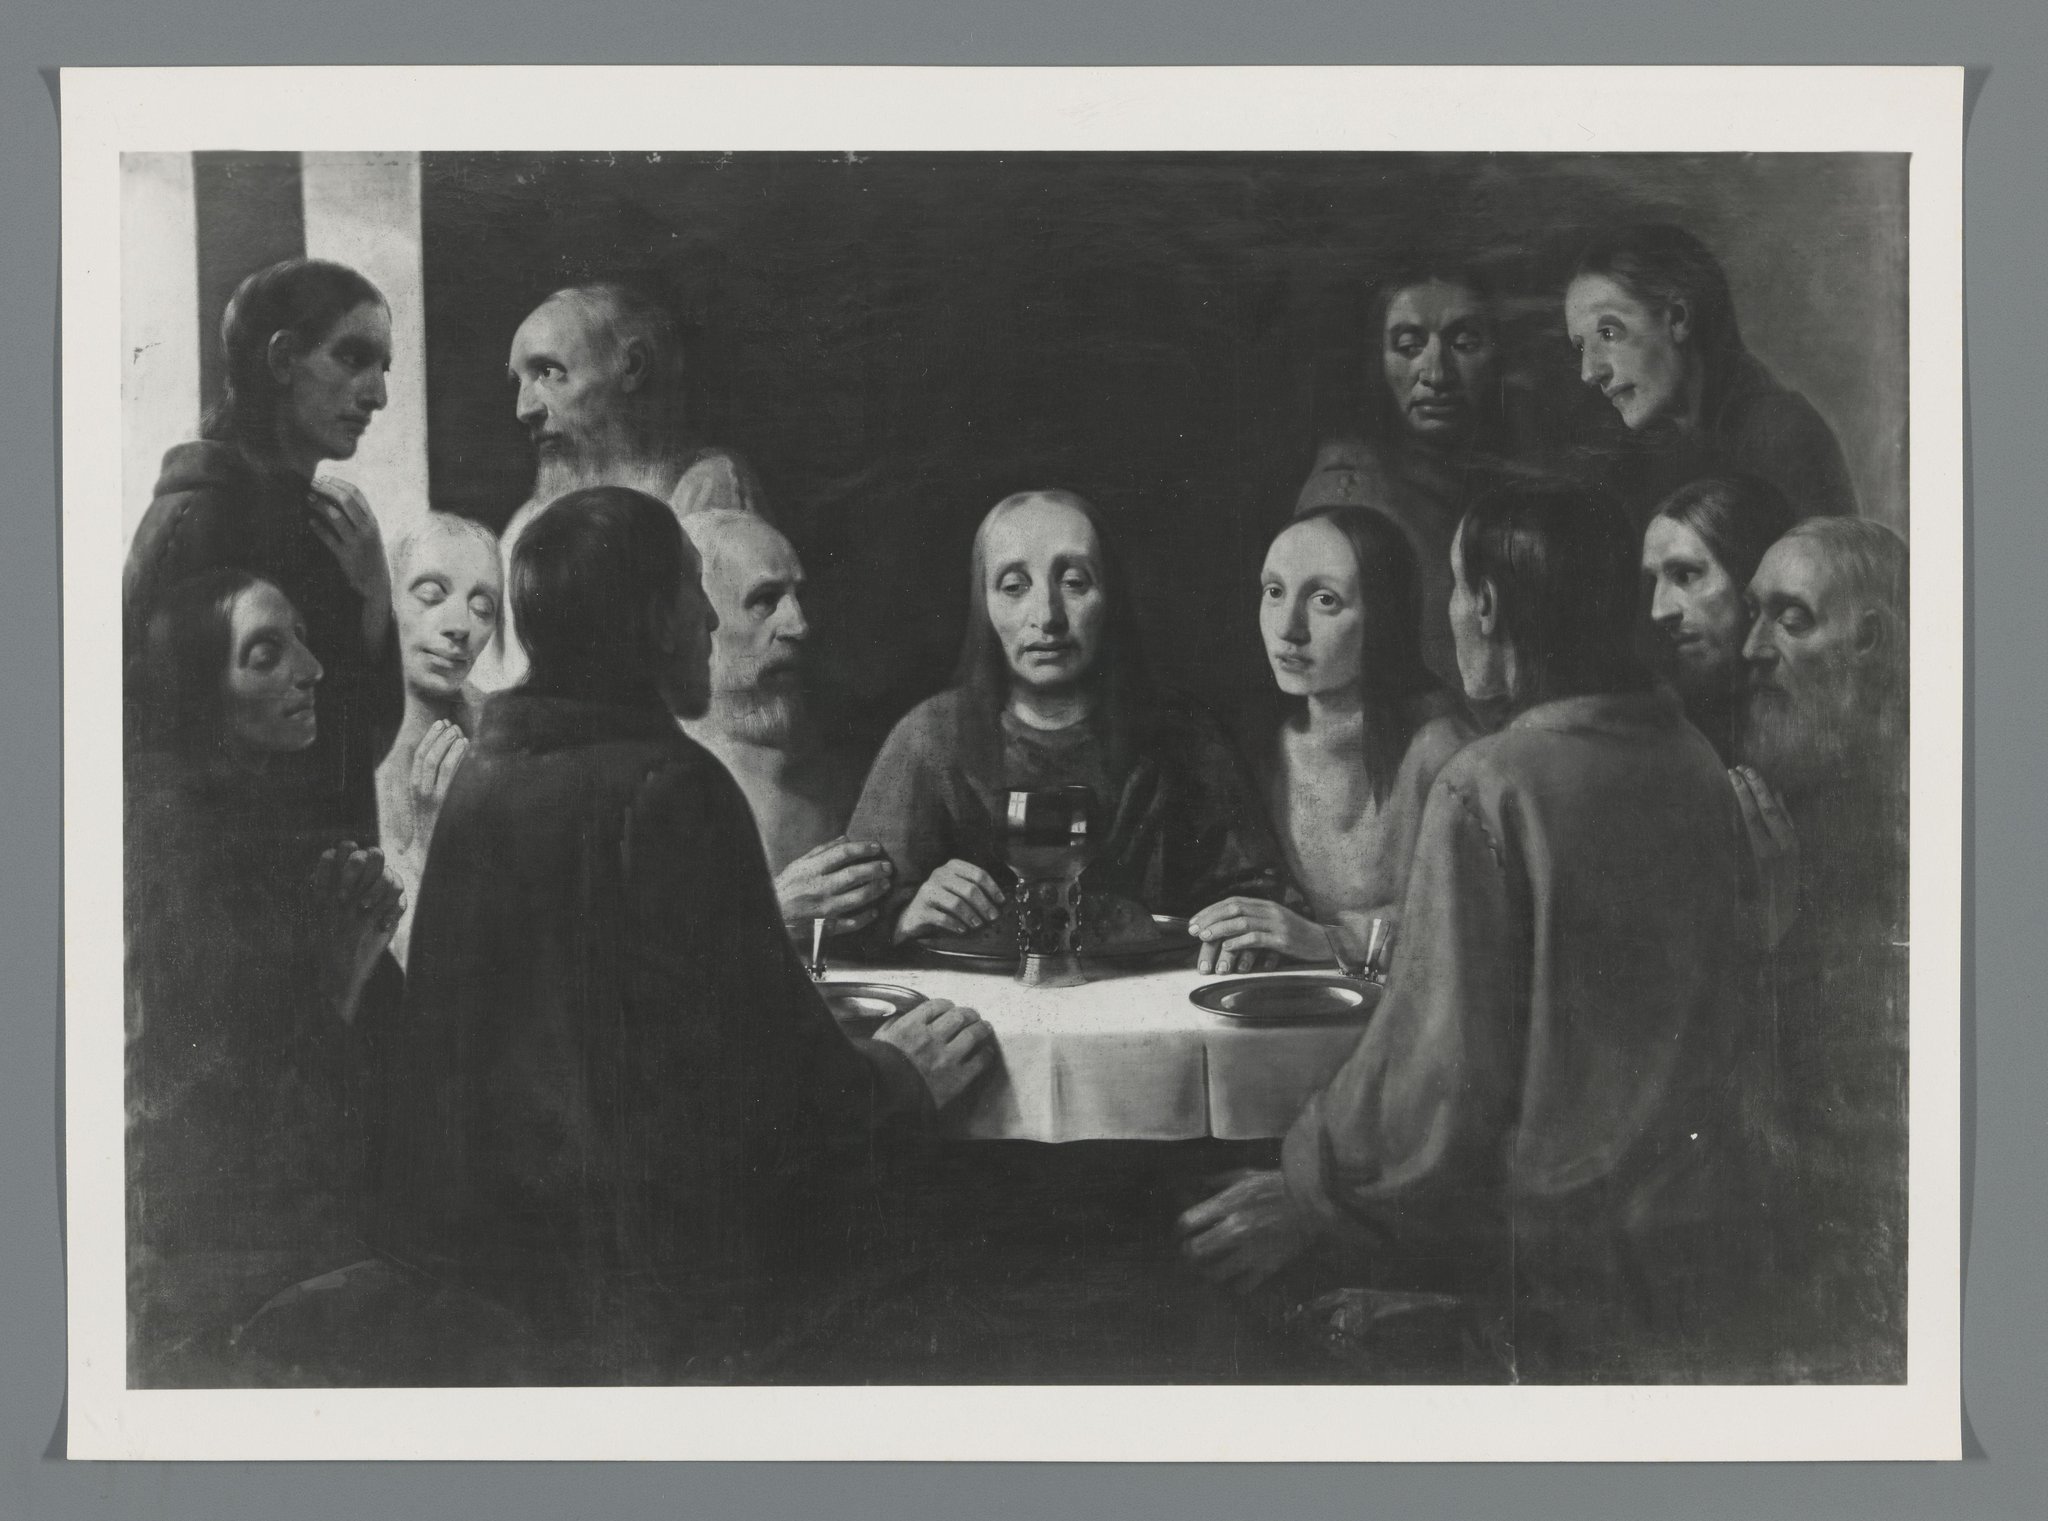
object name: photograph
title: Fotografische reproductie van een (detail) schilderij van Han van Meegeren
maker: nico zomer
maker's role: fotograaf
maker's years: 1910-1988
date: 1908-1948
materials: photographic support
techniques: gelatin silver print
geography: amsterdam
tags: picture, painting